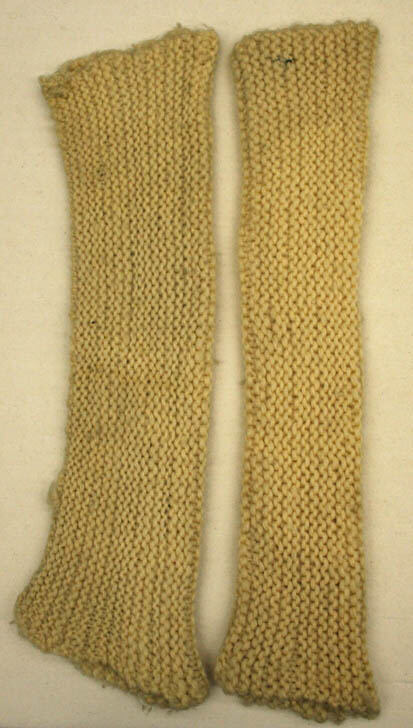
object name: stocking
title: Stockings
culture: british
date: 1801-1833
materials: wool